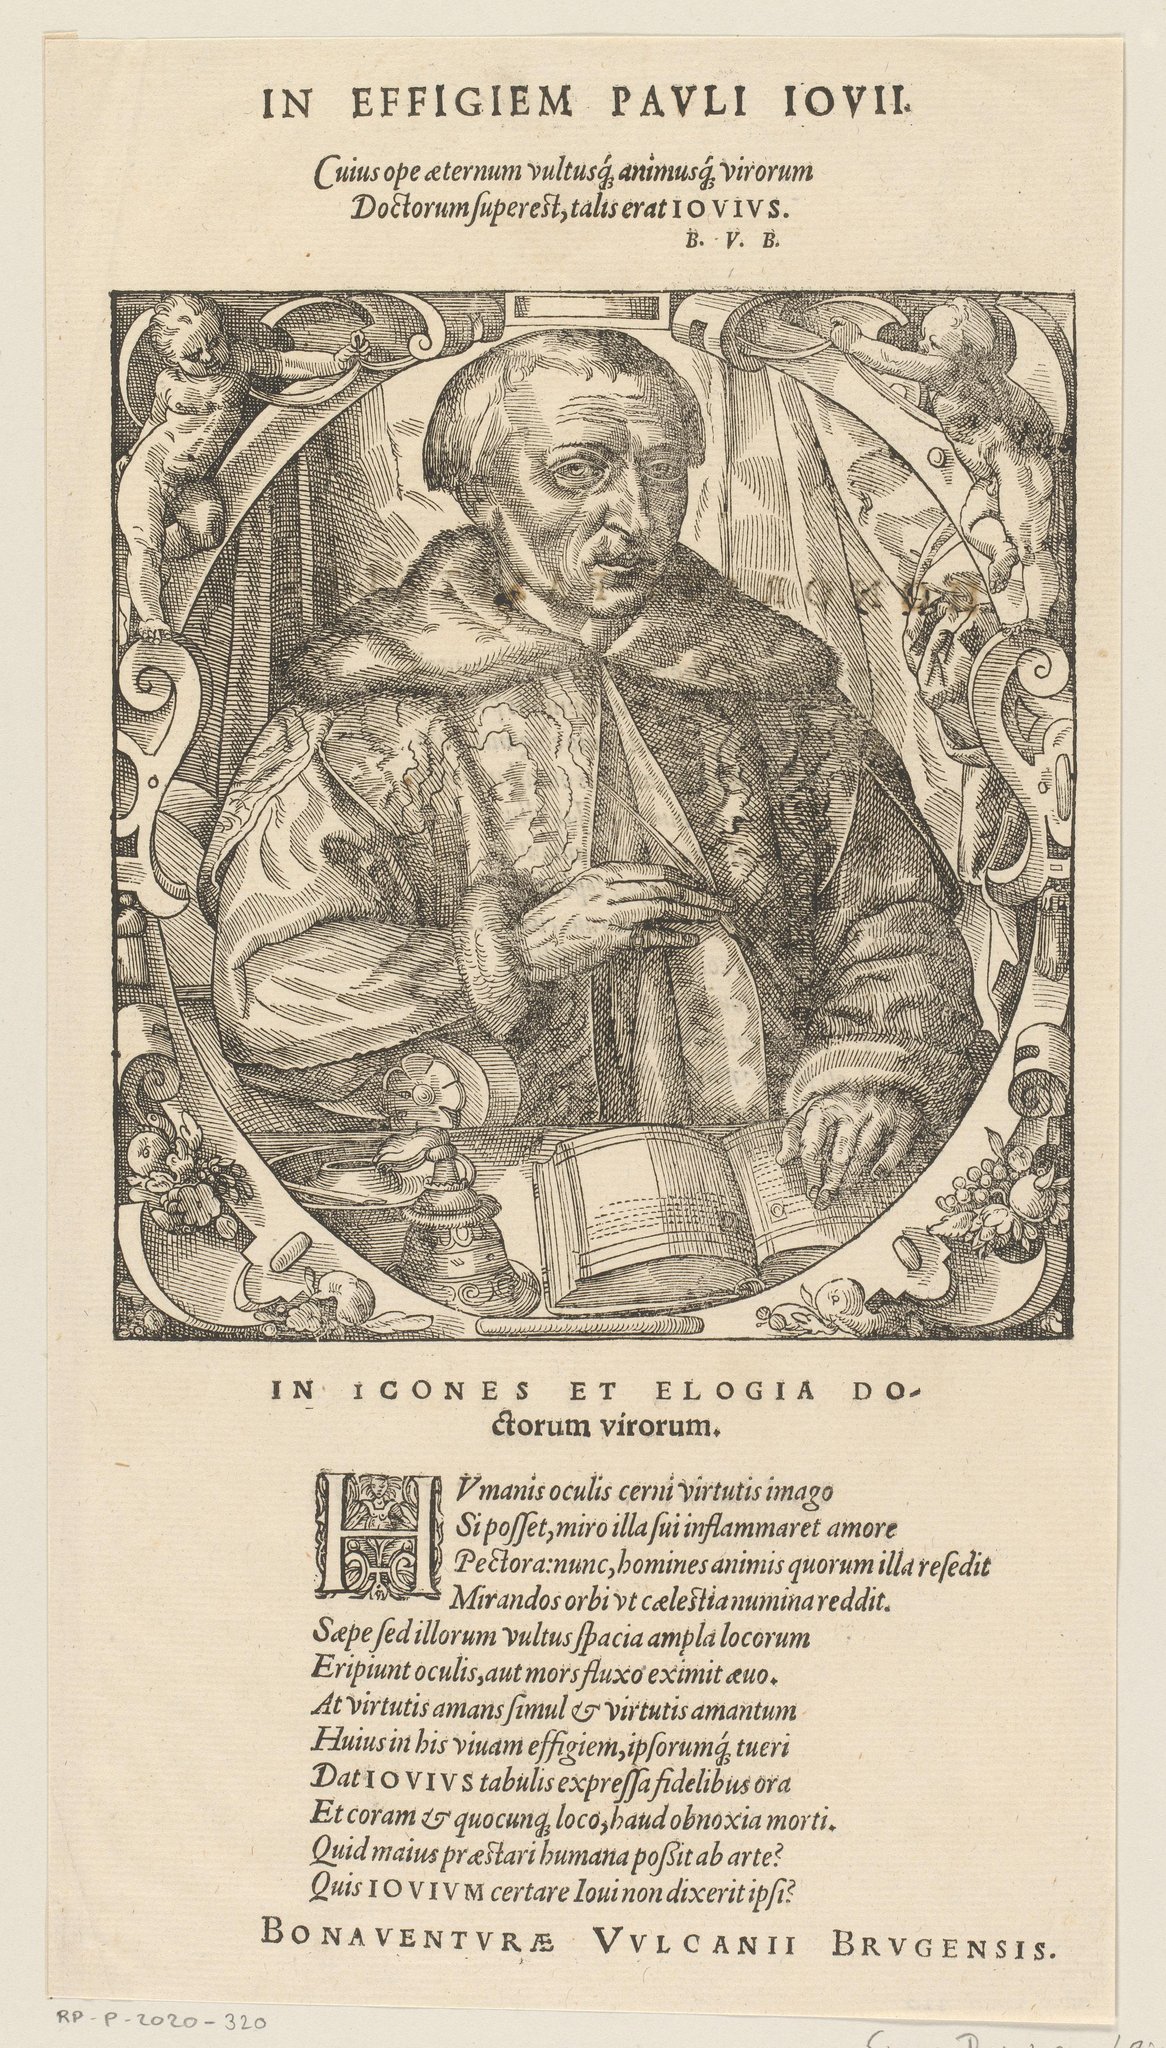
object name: book illustration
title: Portret van Paolo Giovio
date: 1577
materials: paper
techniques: letterpress printing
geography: basel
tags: historical persons, portrait of a writer, book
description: Prent uit: Giovio, Paolo. Elogia virorum literis illustrium, quotquot (...). Bazel: Peter Perna, 1577. Prent eerder gebruikt in: Giovio, Paolo. Elogia virorum bellica virtute illustrium (...). Bazel: Peter Perna, 1575. Prent ook gebruikt in latere publicaties.